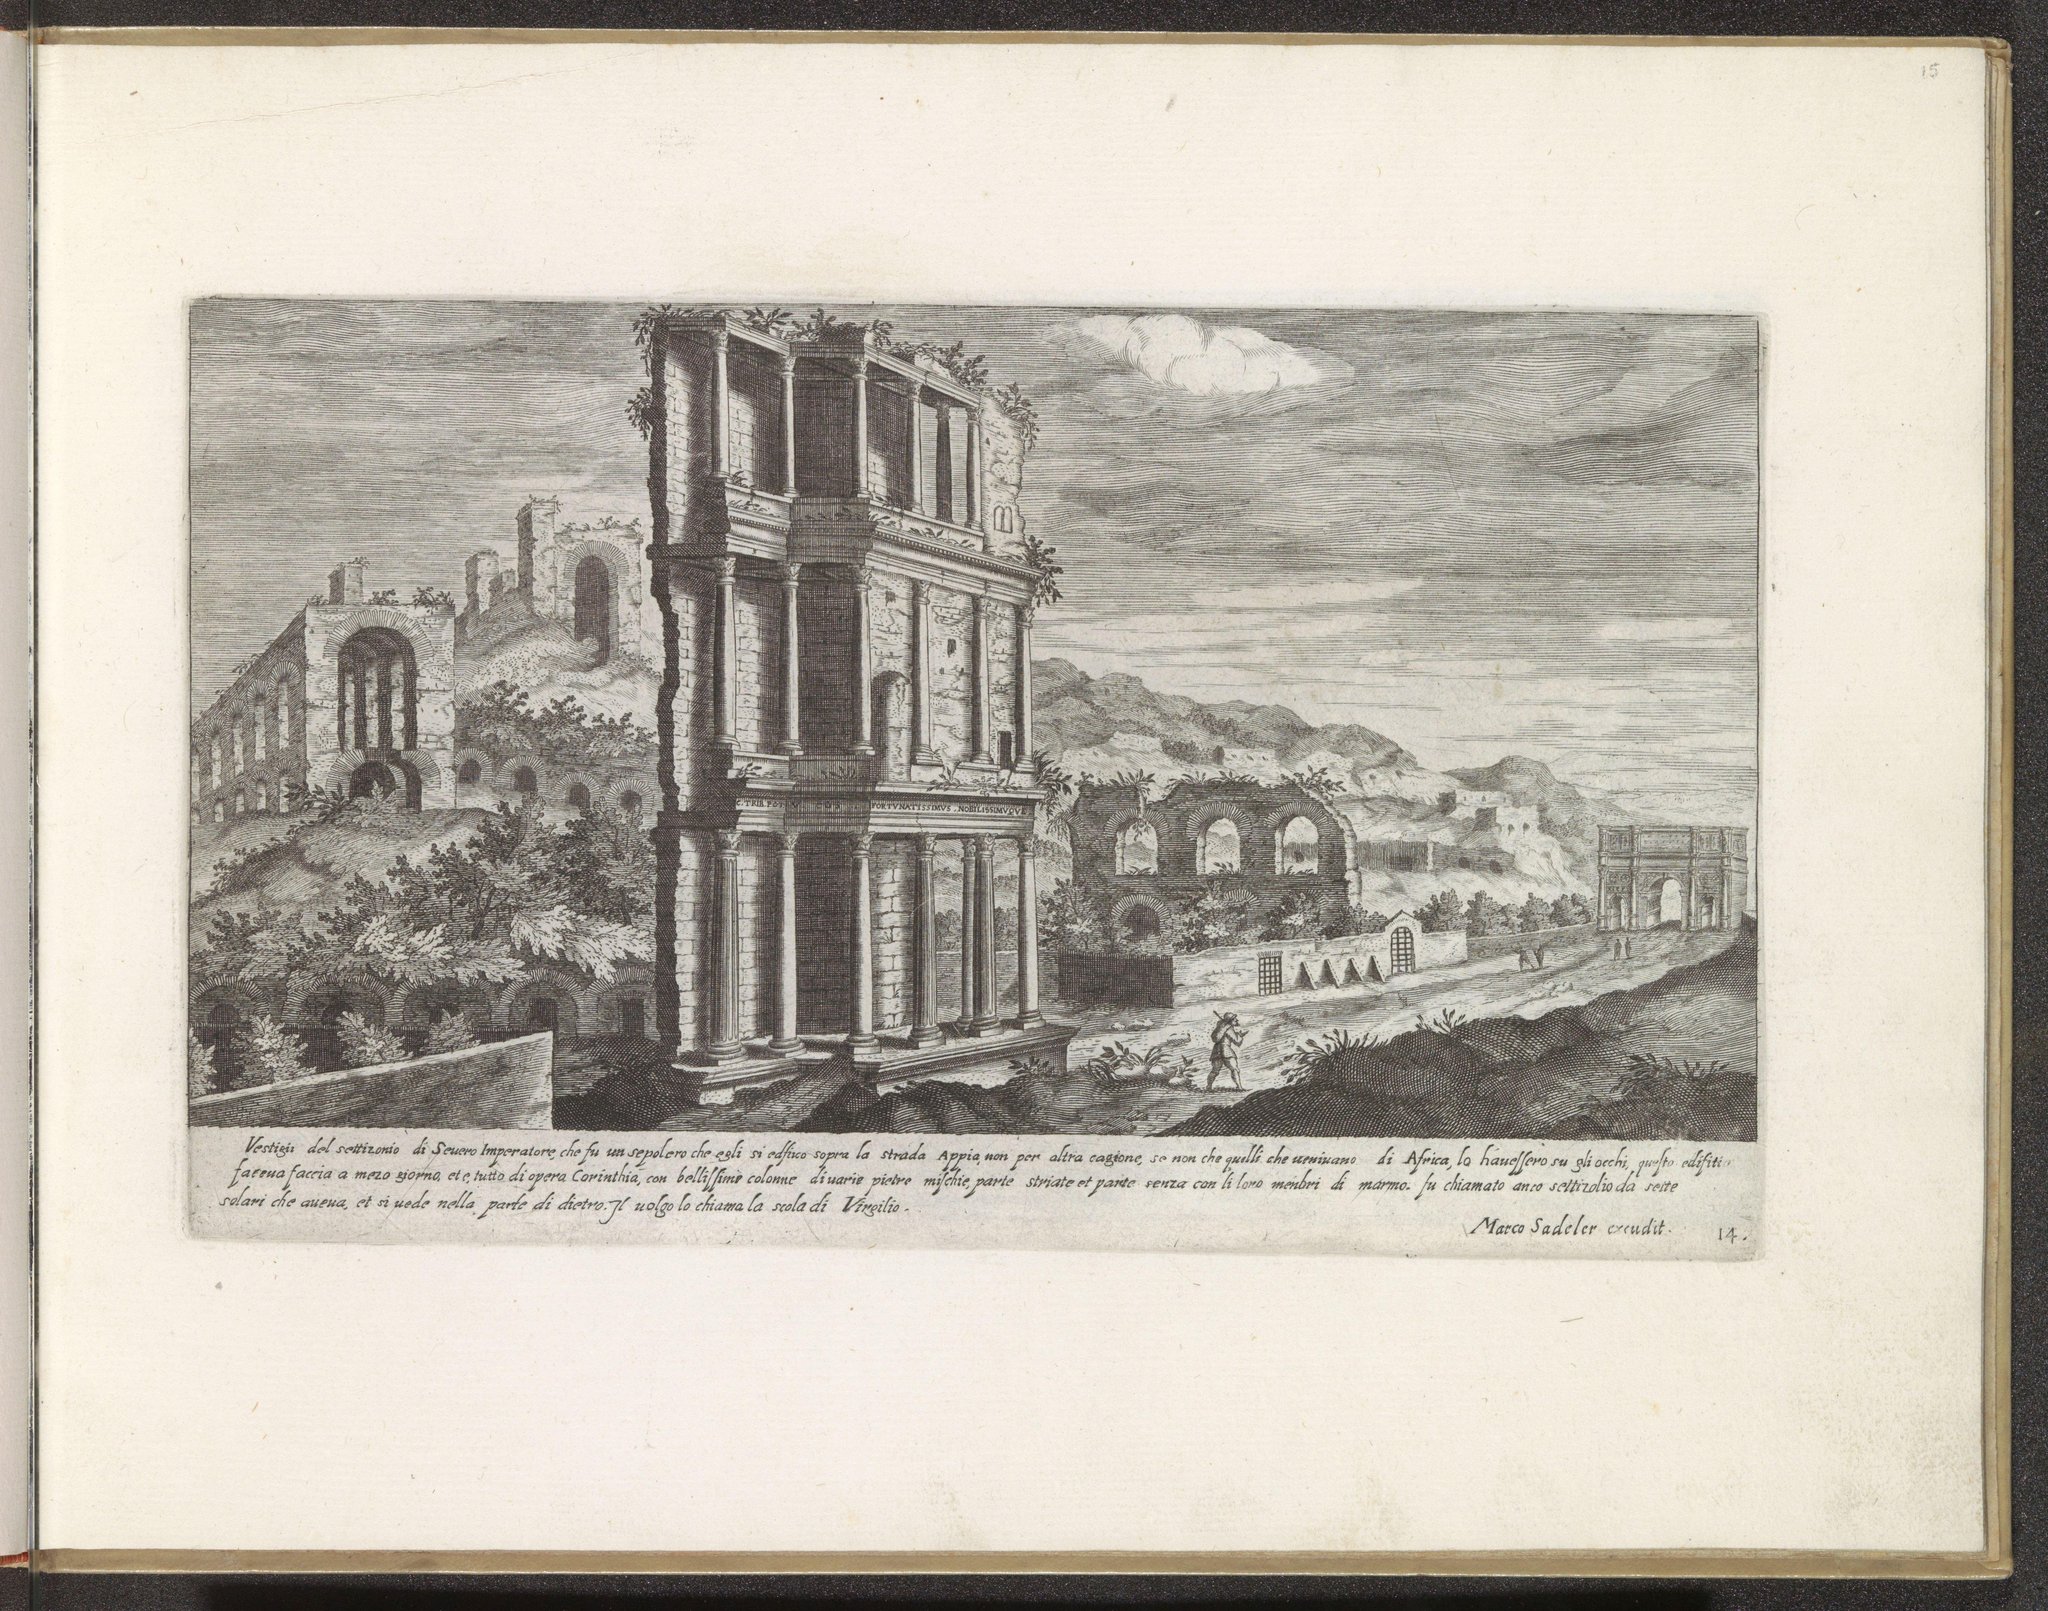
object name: print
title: Vestigi della antichita di Roma, Tivoli, Pozzuolo et altri Luochi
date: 1606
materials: paper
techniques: engraving, etching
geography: prague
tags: rome, arch of constantine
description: Het Septizonium in Rome. Links bogen van de Aqua Claudia en rechts de Boog van Constantijn. In de ondermarge drie regels tekst in het Italiaans. De prent maakt deel uit van een album.